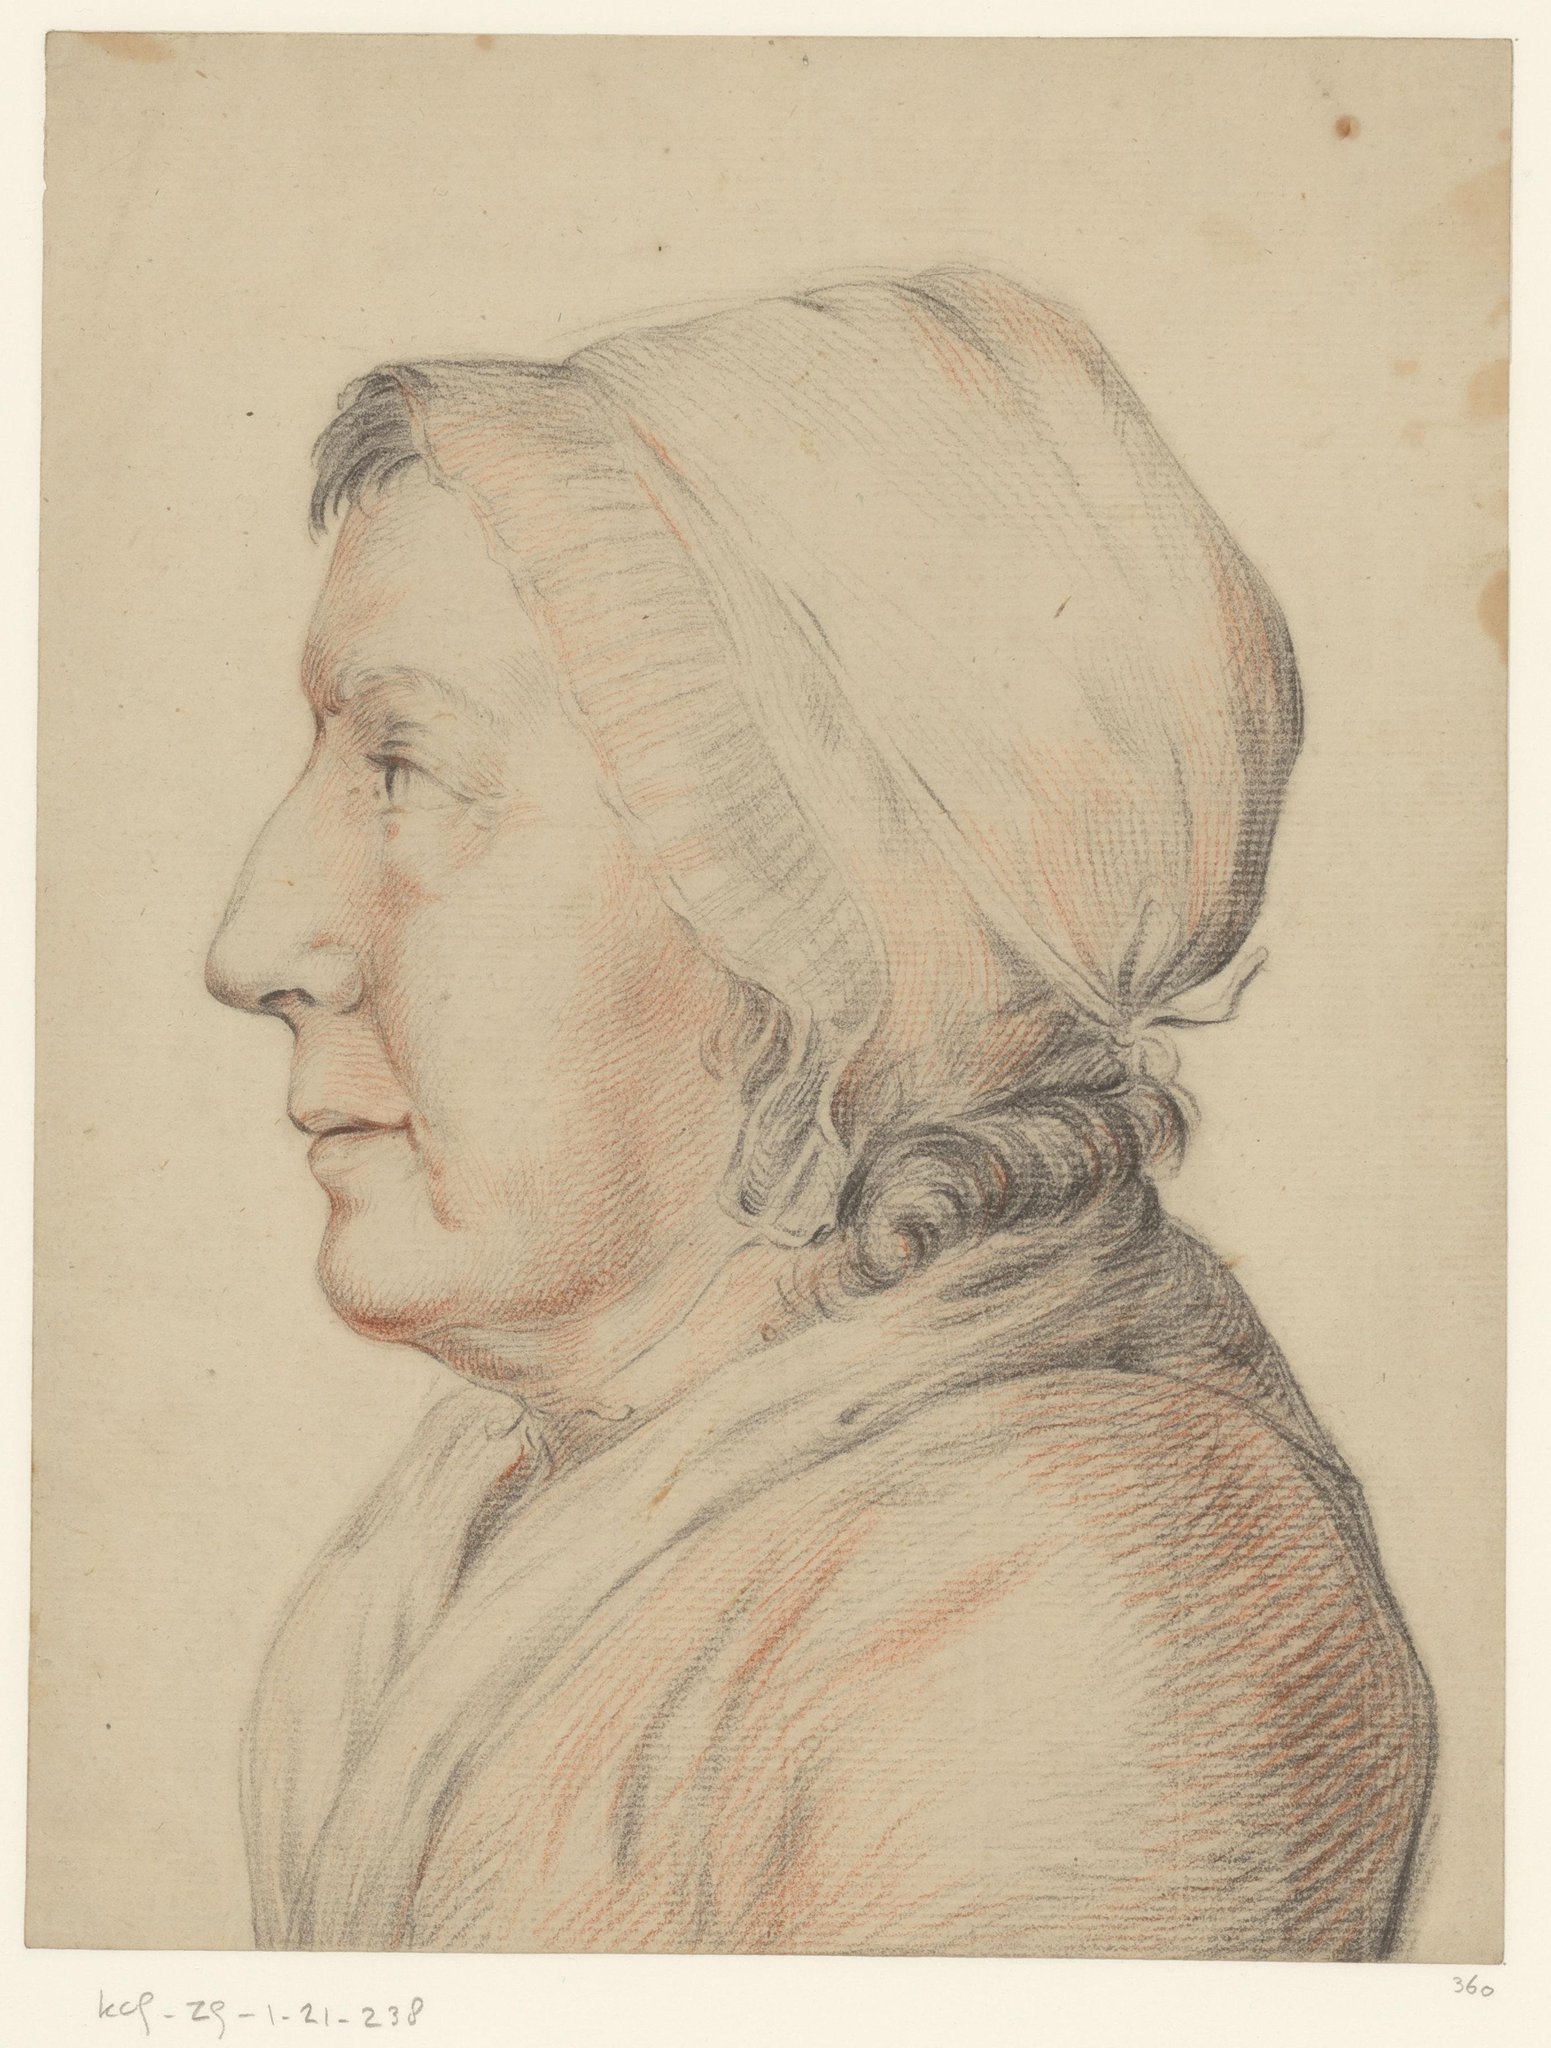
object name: drawing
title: Zijaanzicht van een oude vrouw met muts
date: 1800-1849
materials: chalk, paper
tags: old woman, head-gear: cap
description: Onderwerpsrubrieken binnen de Atlas Zeden en Gewoonten: Zeden en Gewoonten in Engeren Zin, De Kleeding, Kleederdrachten (tijdvakken), Het begin der 19de eeuw. Mannen en vrouwen.